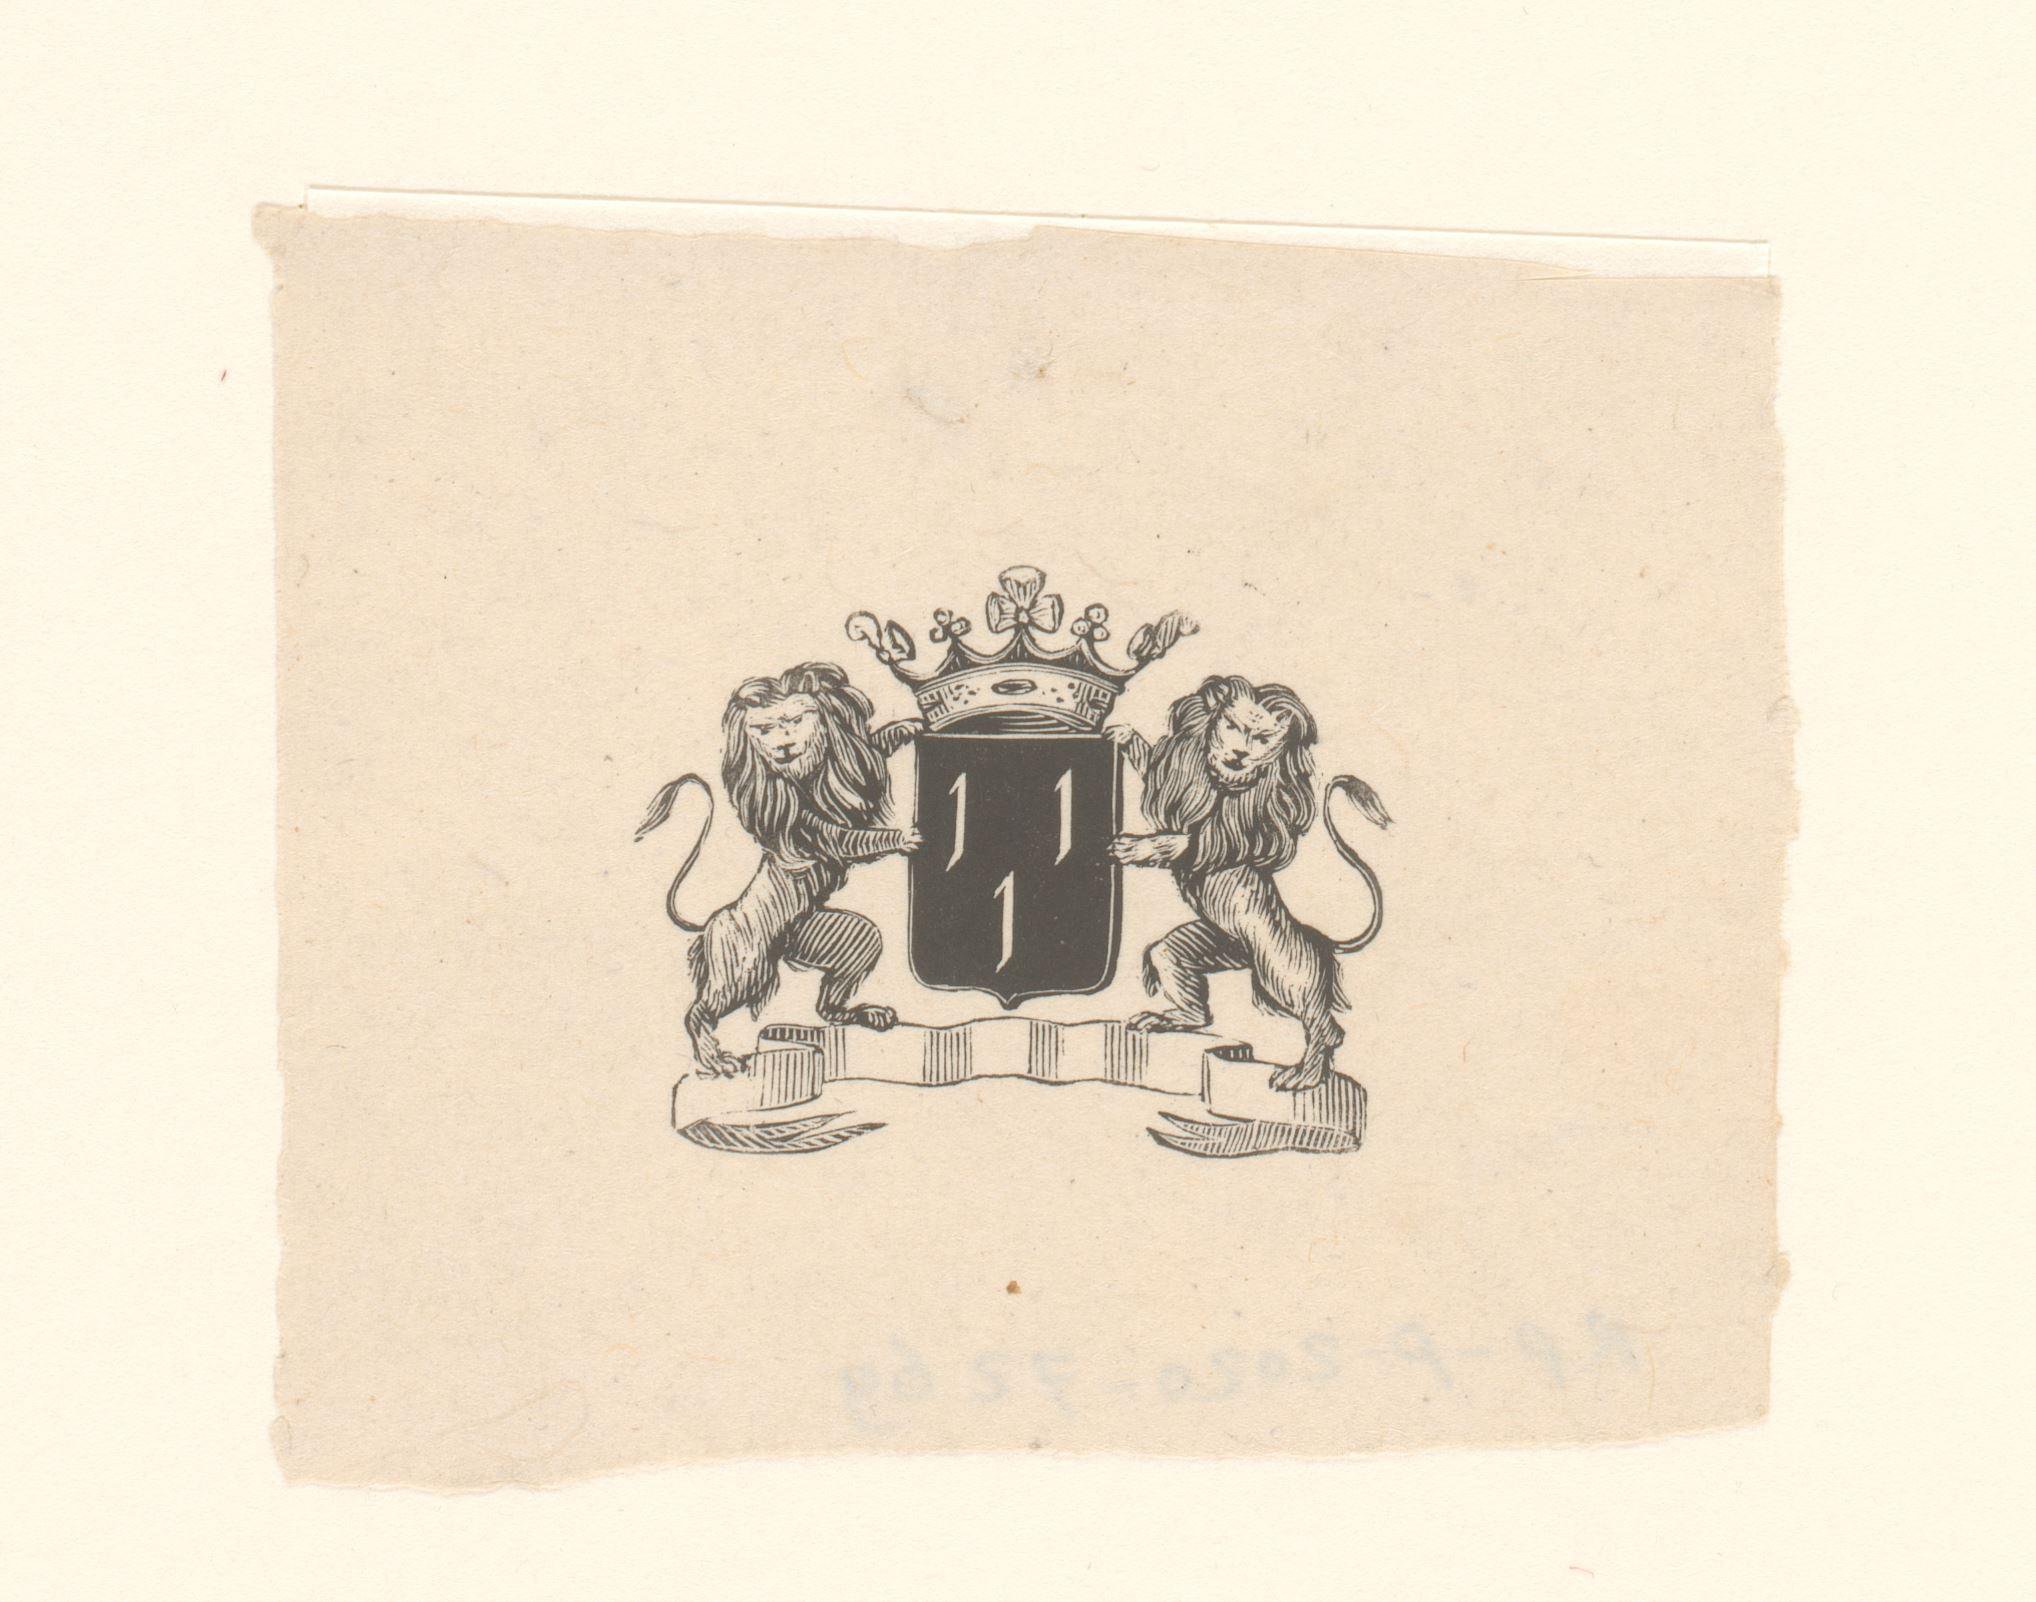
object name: print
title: Wapen van Purmerend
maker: Anonymous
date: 1815-1899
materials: paper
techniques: engraving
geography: netherlands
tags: coat of arms (as symbol of the state, etc.), netherlands